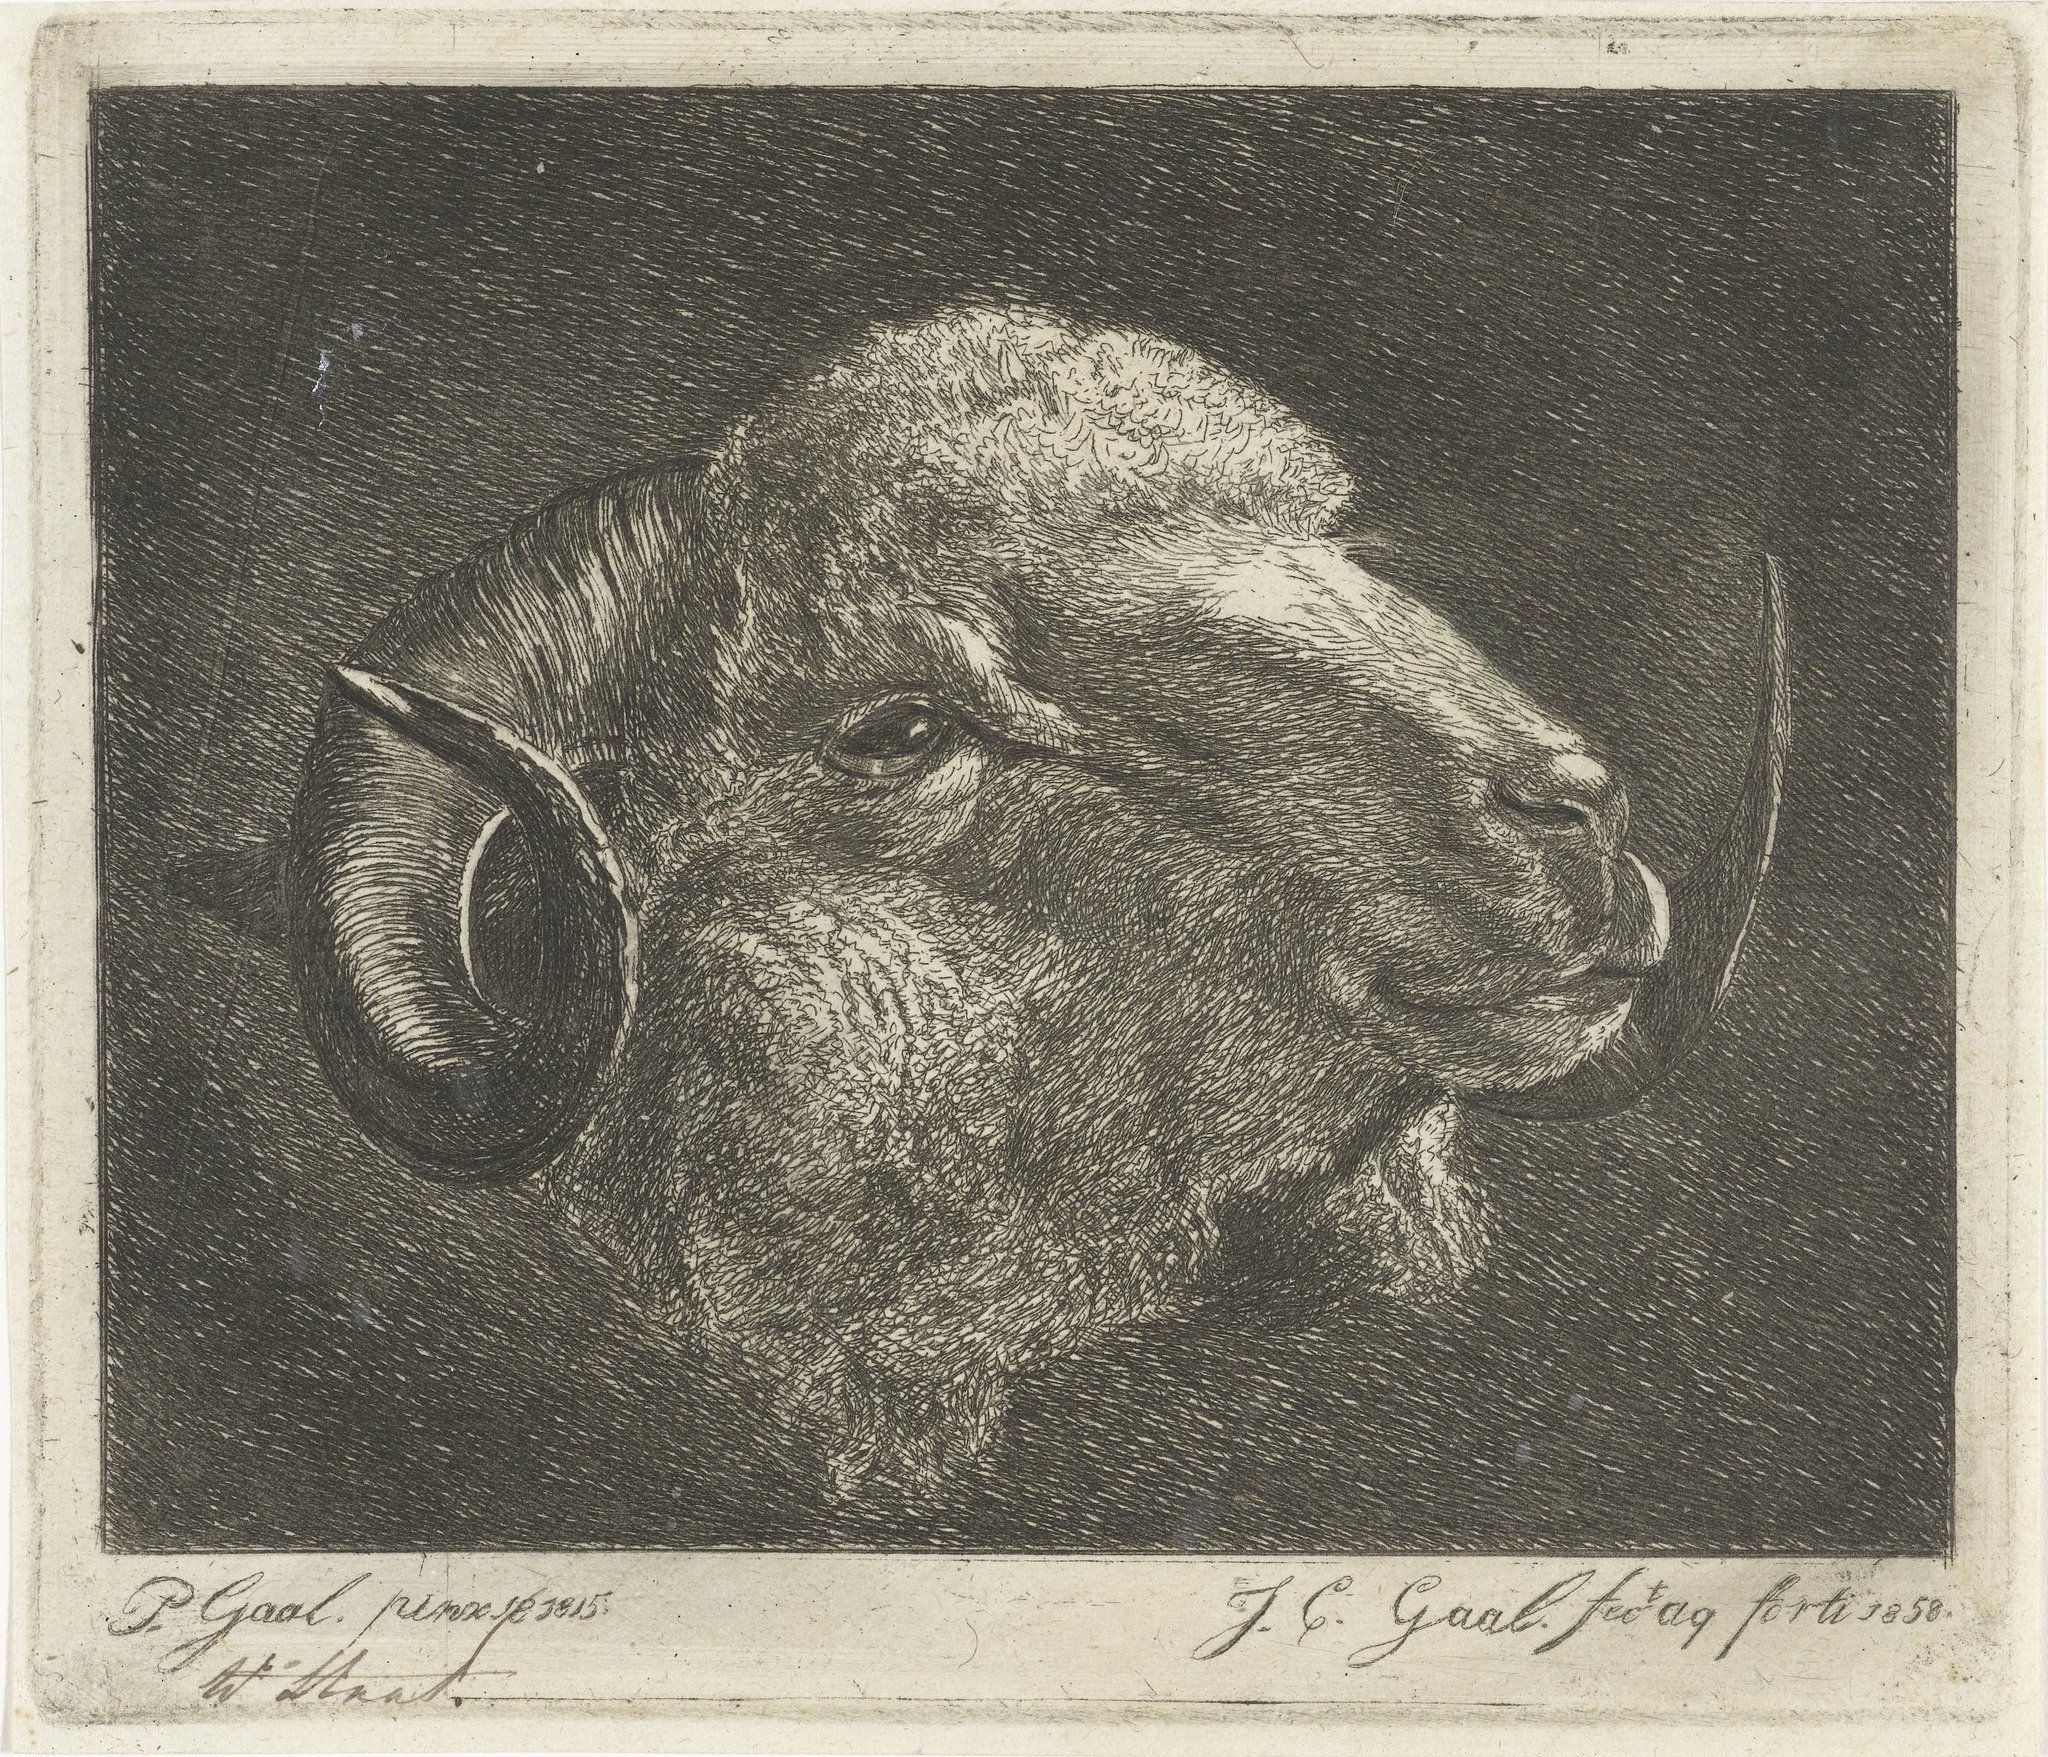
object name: print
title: Kop van een ram met naar achteren gedraaide hoorns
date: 1858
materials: paper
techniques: etching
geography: netherlands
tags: ram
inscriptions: collector's mark: Lugt 2228